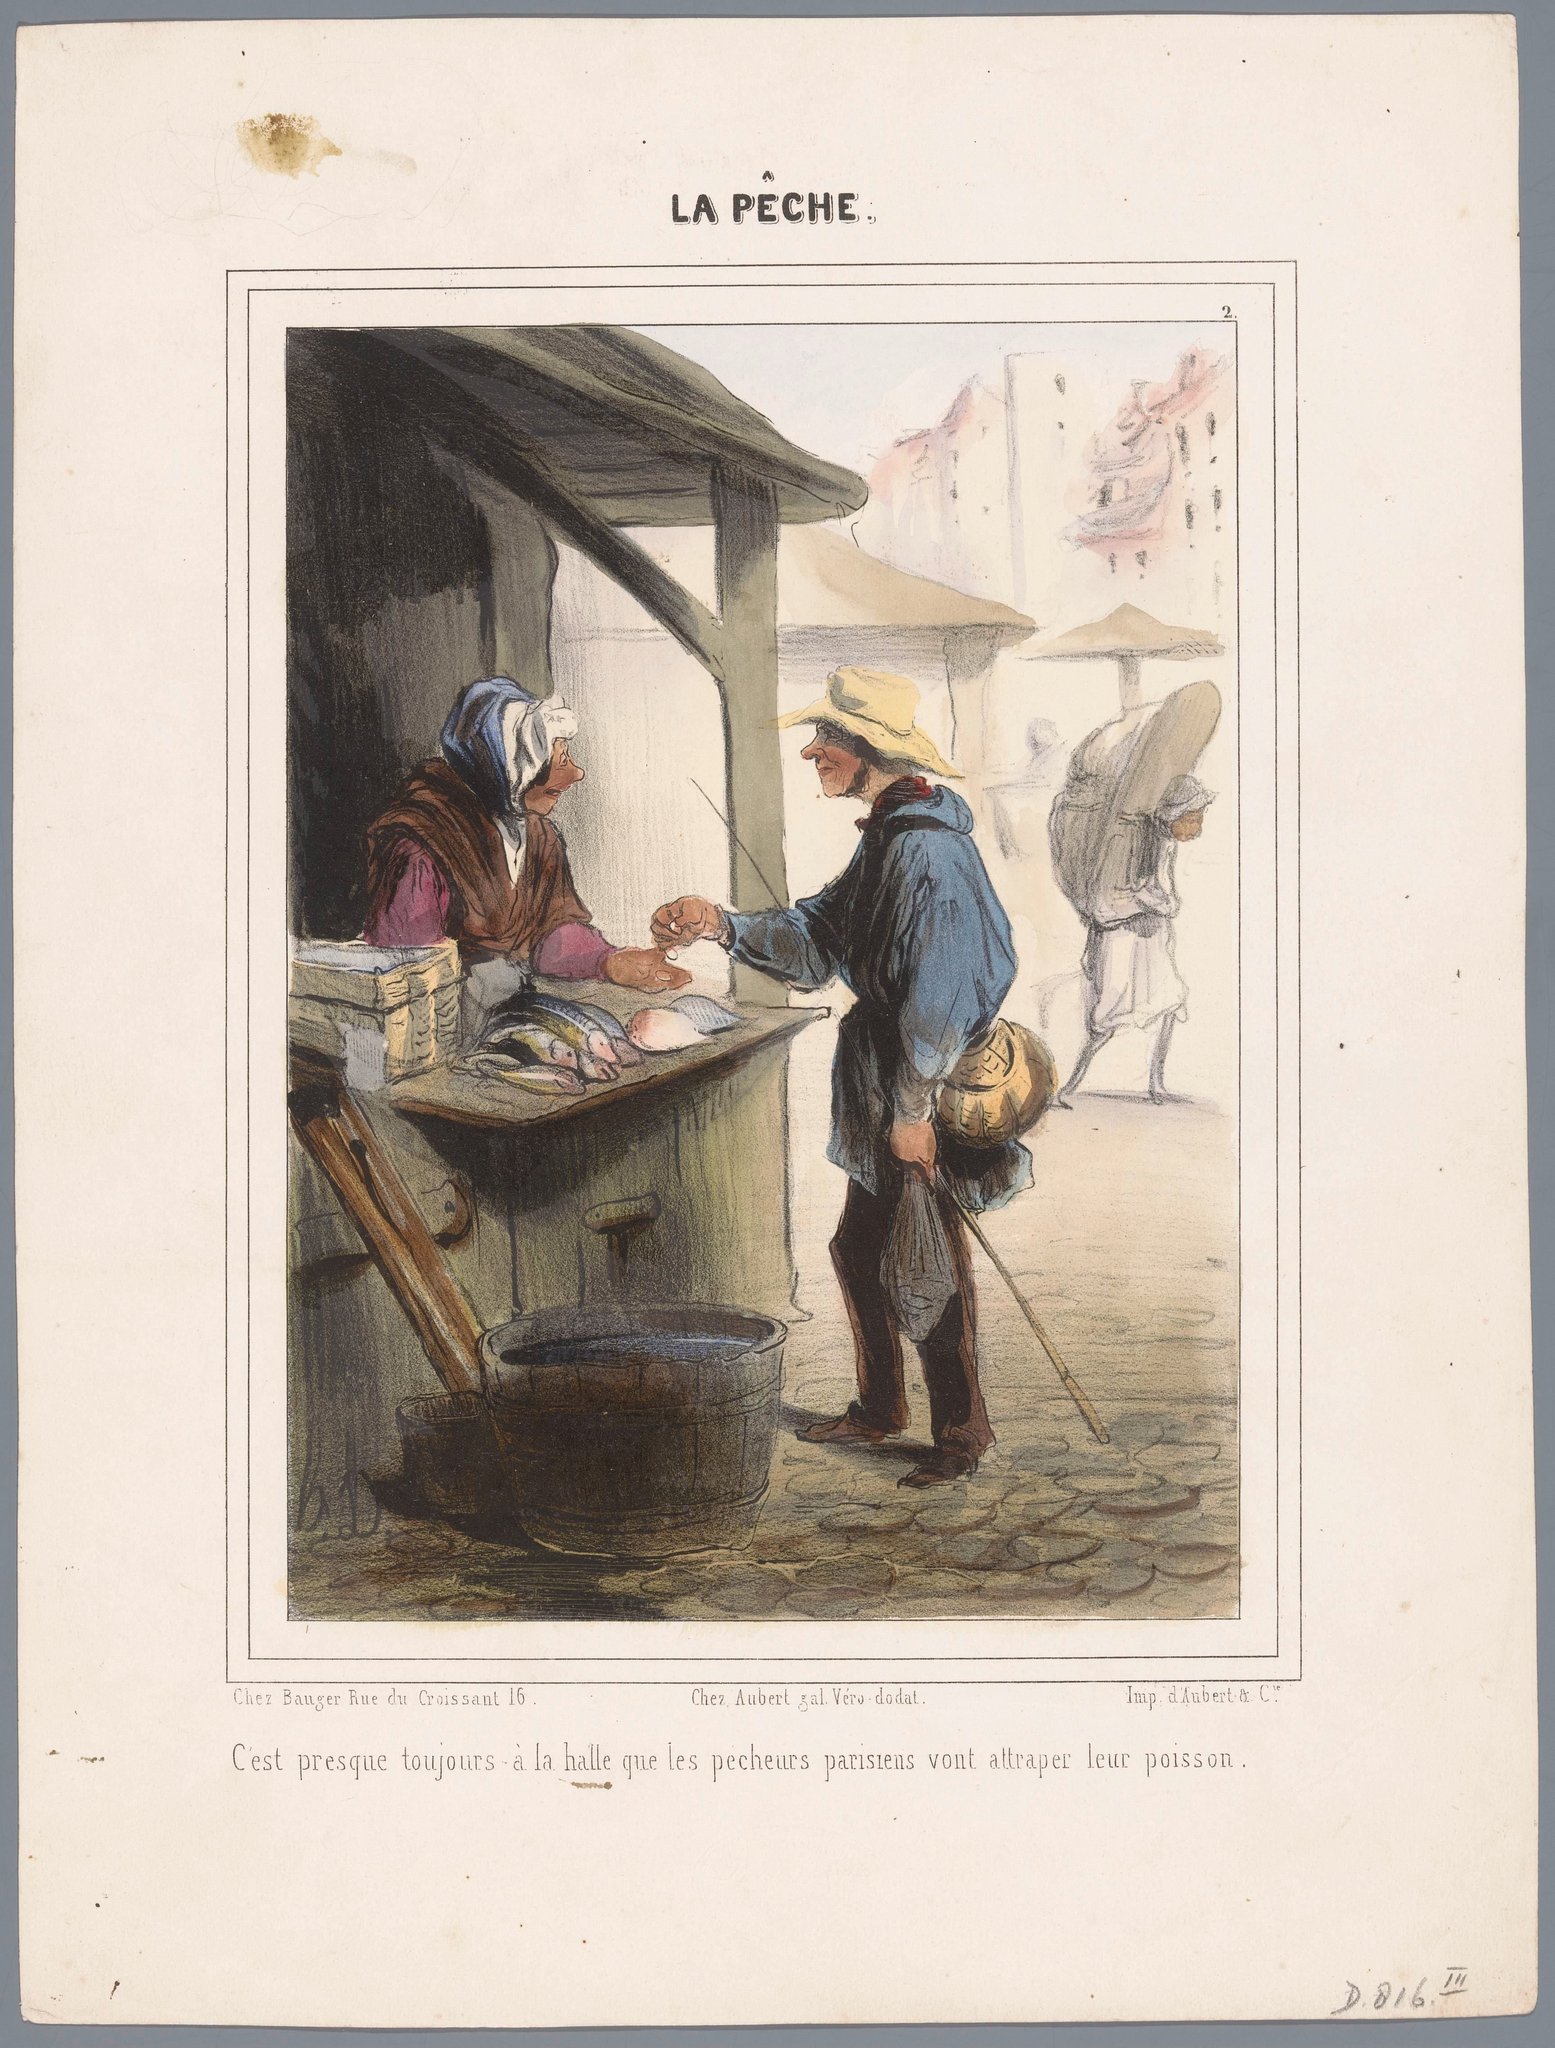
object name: cartoon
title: C'est presque toujours à la halle (...)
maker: honoré daumier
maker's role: draughtsman, painter, print maker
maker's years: 1808-1879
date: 1840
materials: paper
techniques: hand coloring, lithograph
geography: paris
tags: commercial fishery, historical persons, market-hall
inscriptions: collector's mark: Lugt 2228a, collector's mark: Lugt 2233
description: Prent mogelijk uit: La Caricature (2e serie) nr. 29, 19 juli 1840.